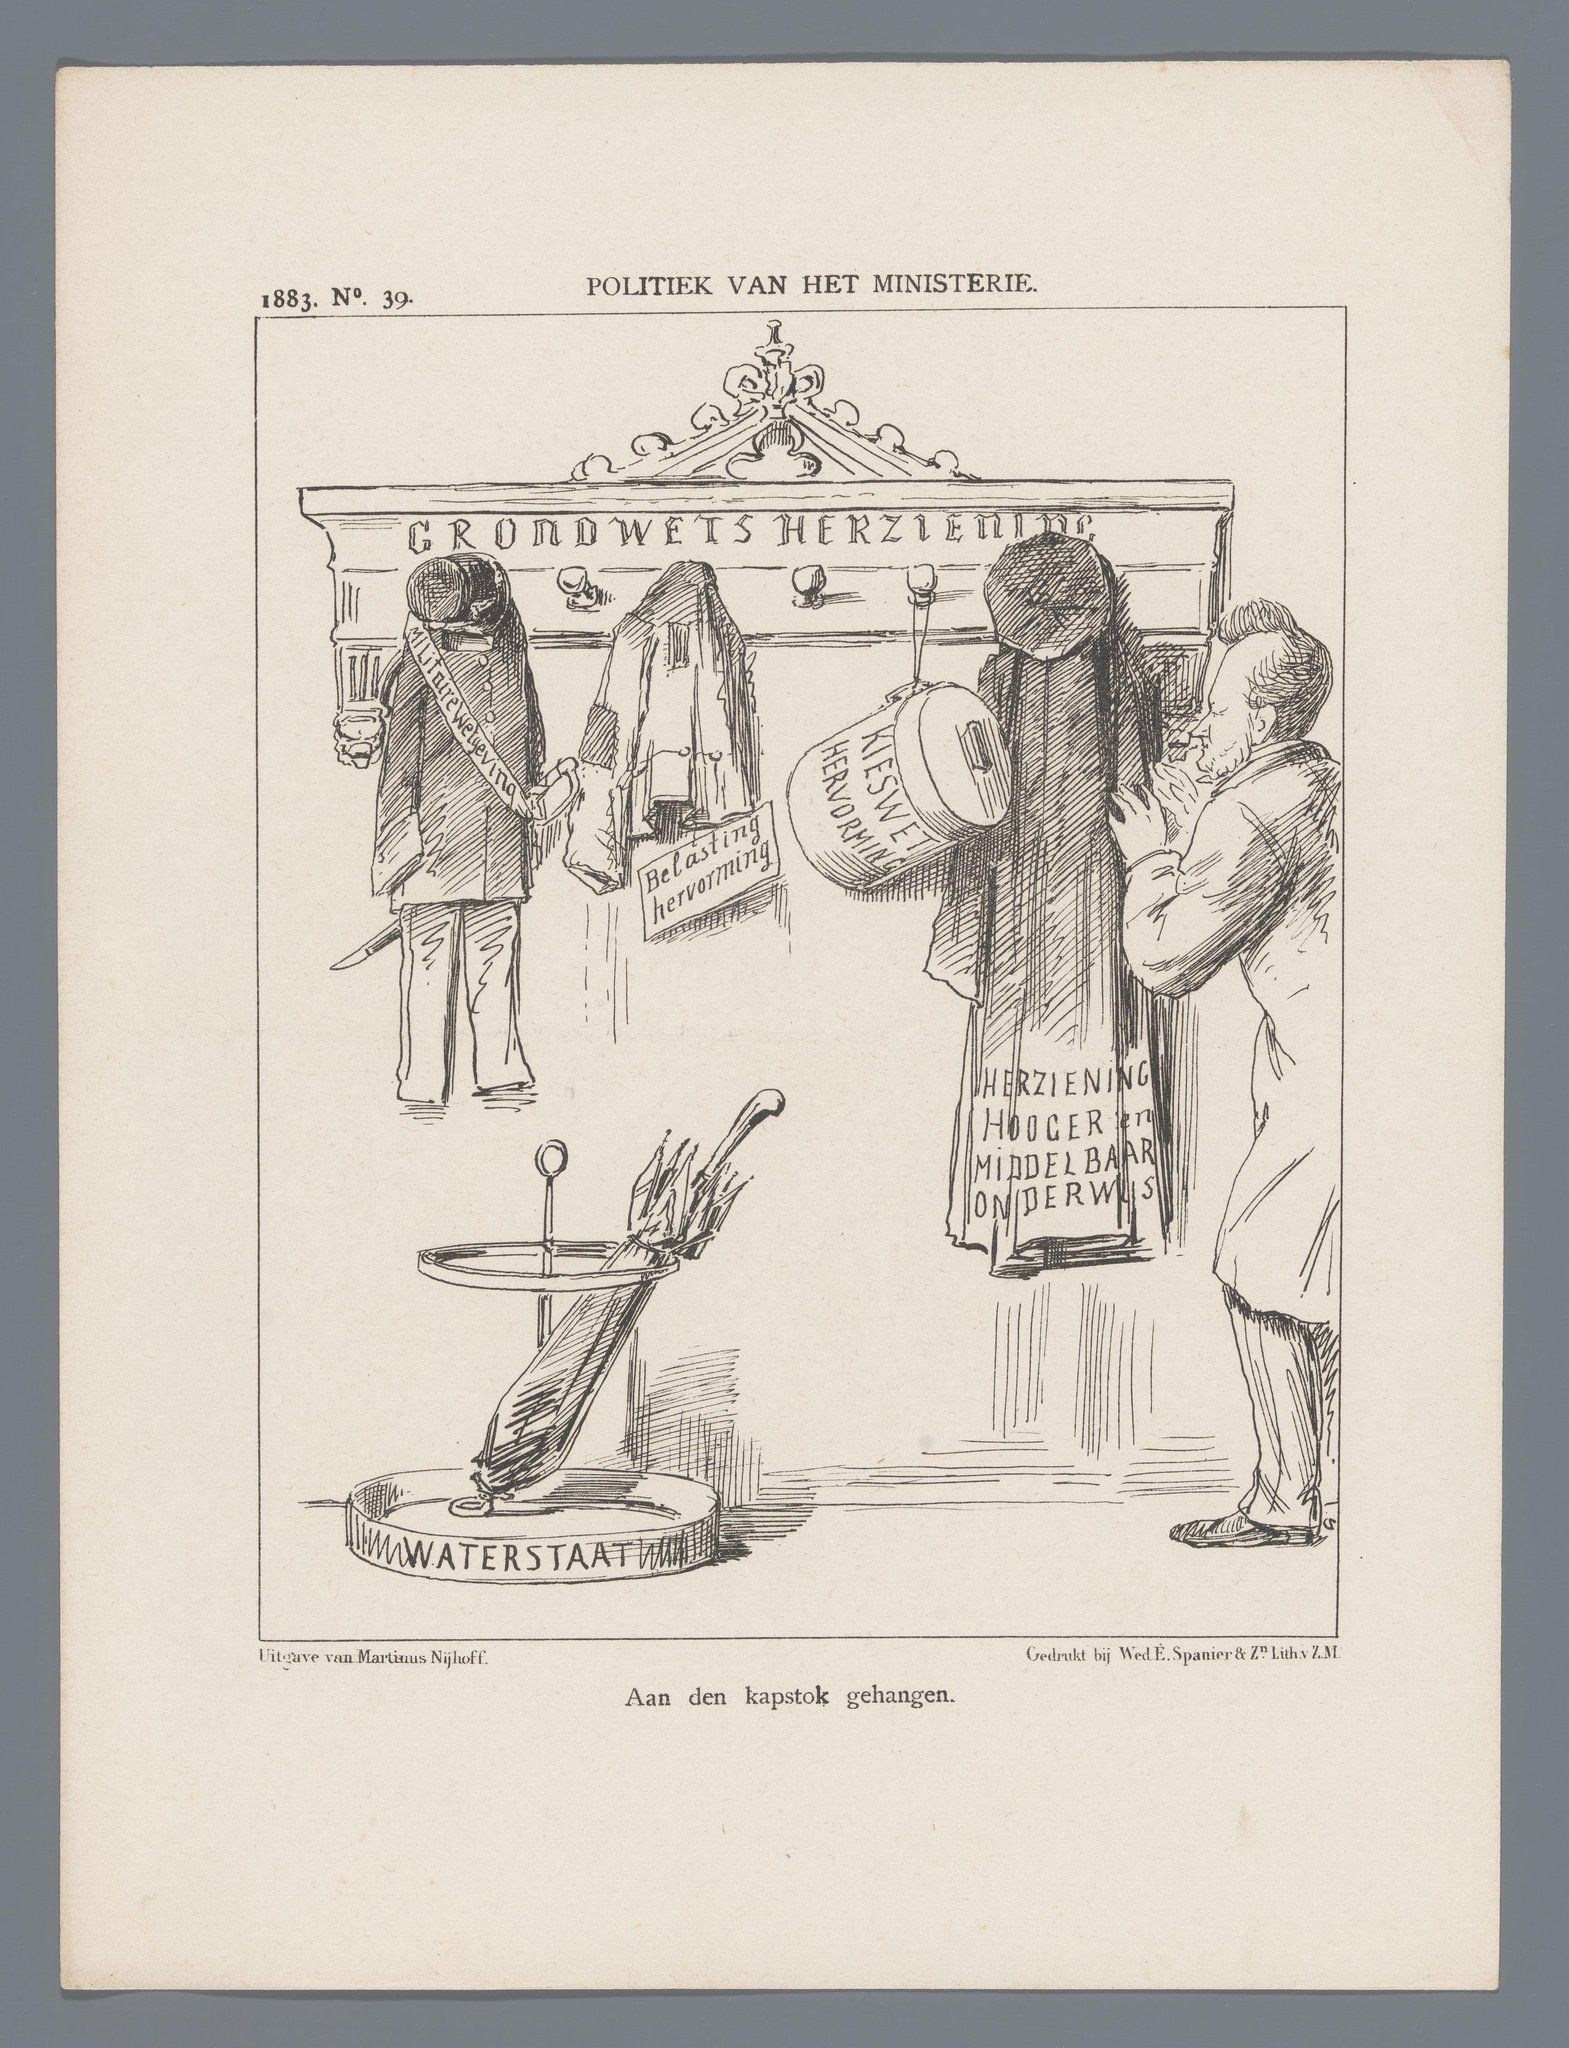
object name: print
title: Spotprent op de uitgestelde hervormingen, 1883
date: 1883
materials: paper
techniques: lithograph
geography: the hague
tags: amsterdam, politician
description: Spotprent op de uitgestelde politieke hervormingen en herzieningen, 1883. Plaat verschenen bij het weekblad De Nederlandsche Spectator, nr. 39, 1883.